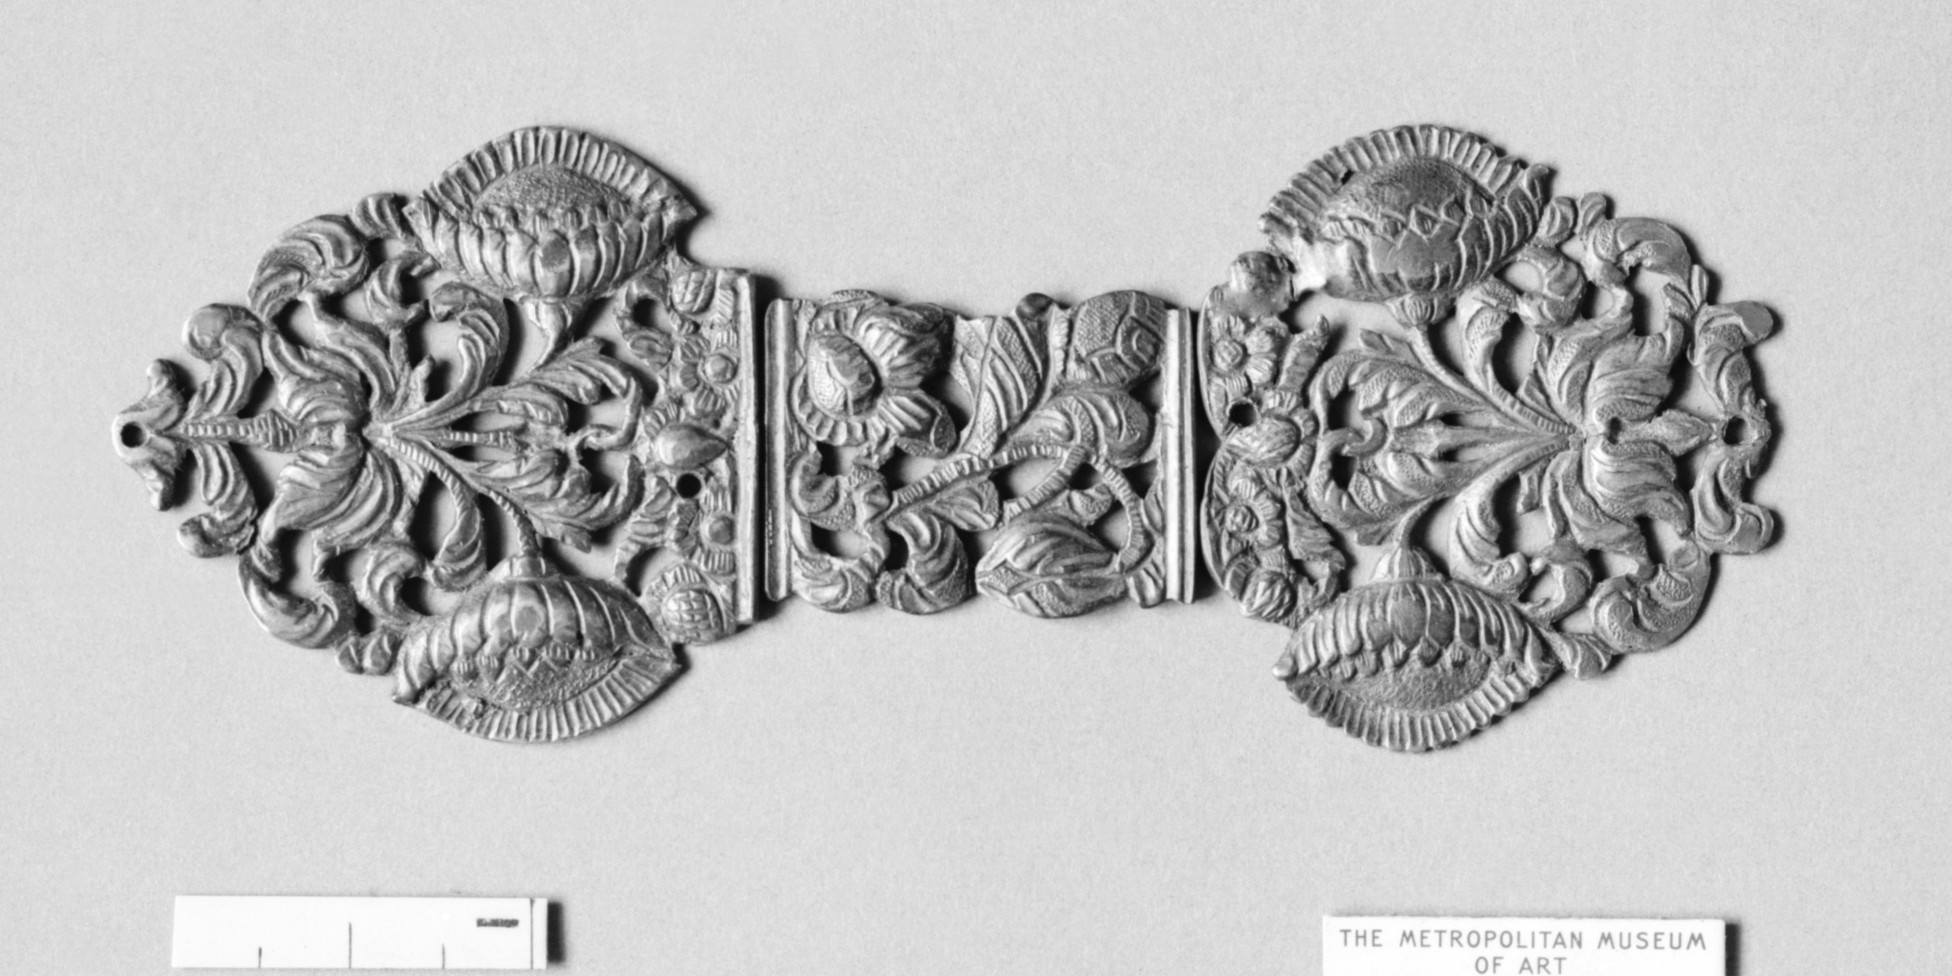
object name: book clasp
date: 1601-1700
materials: silver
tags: plants